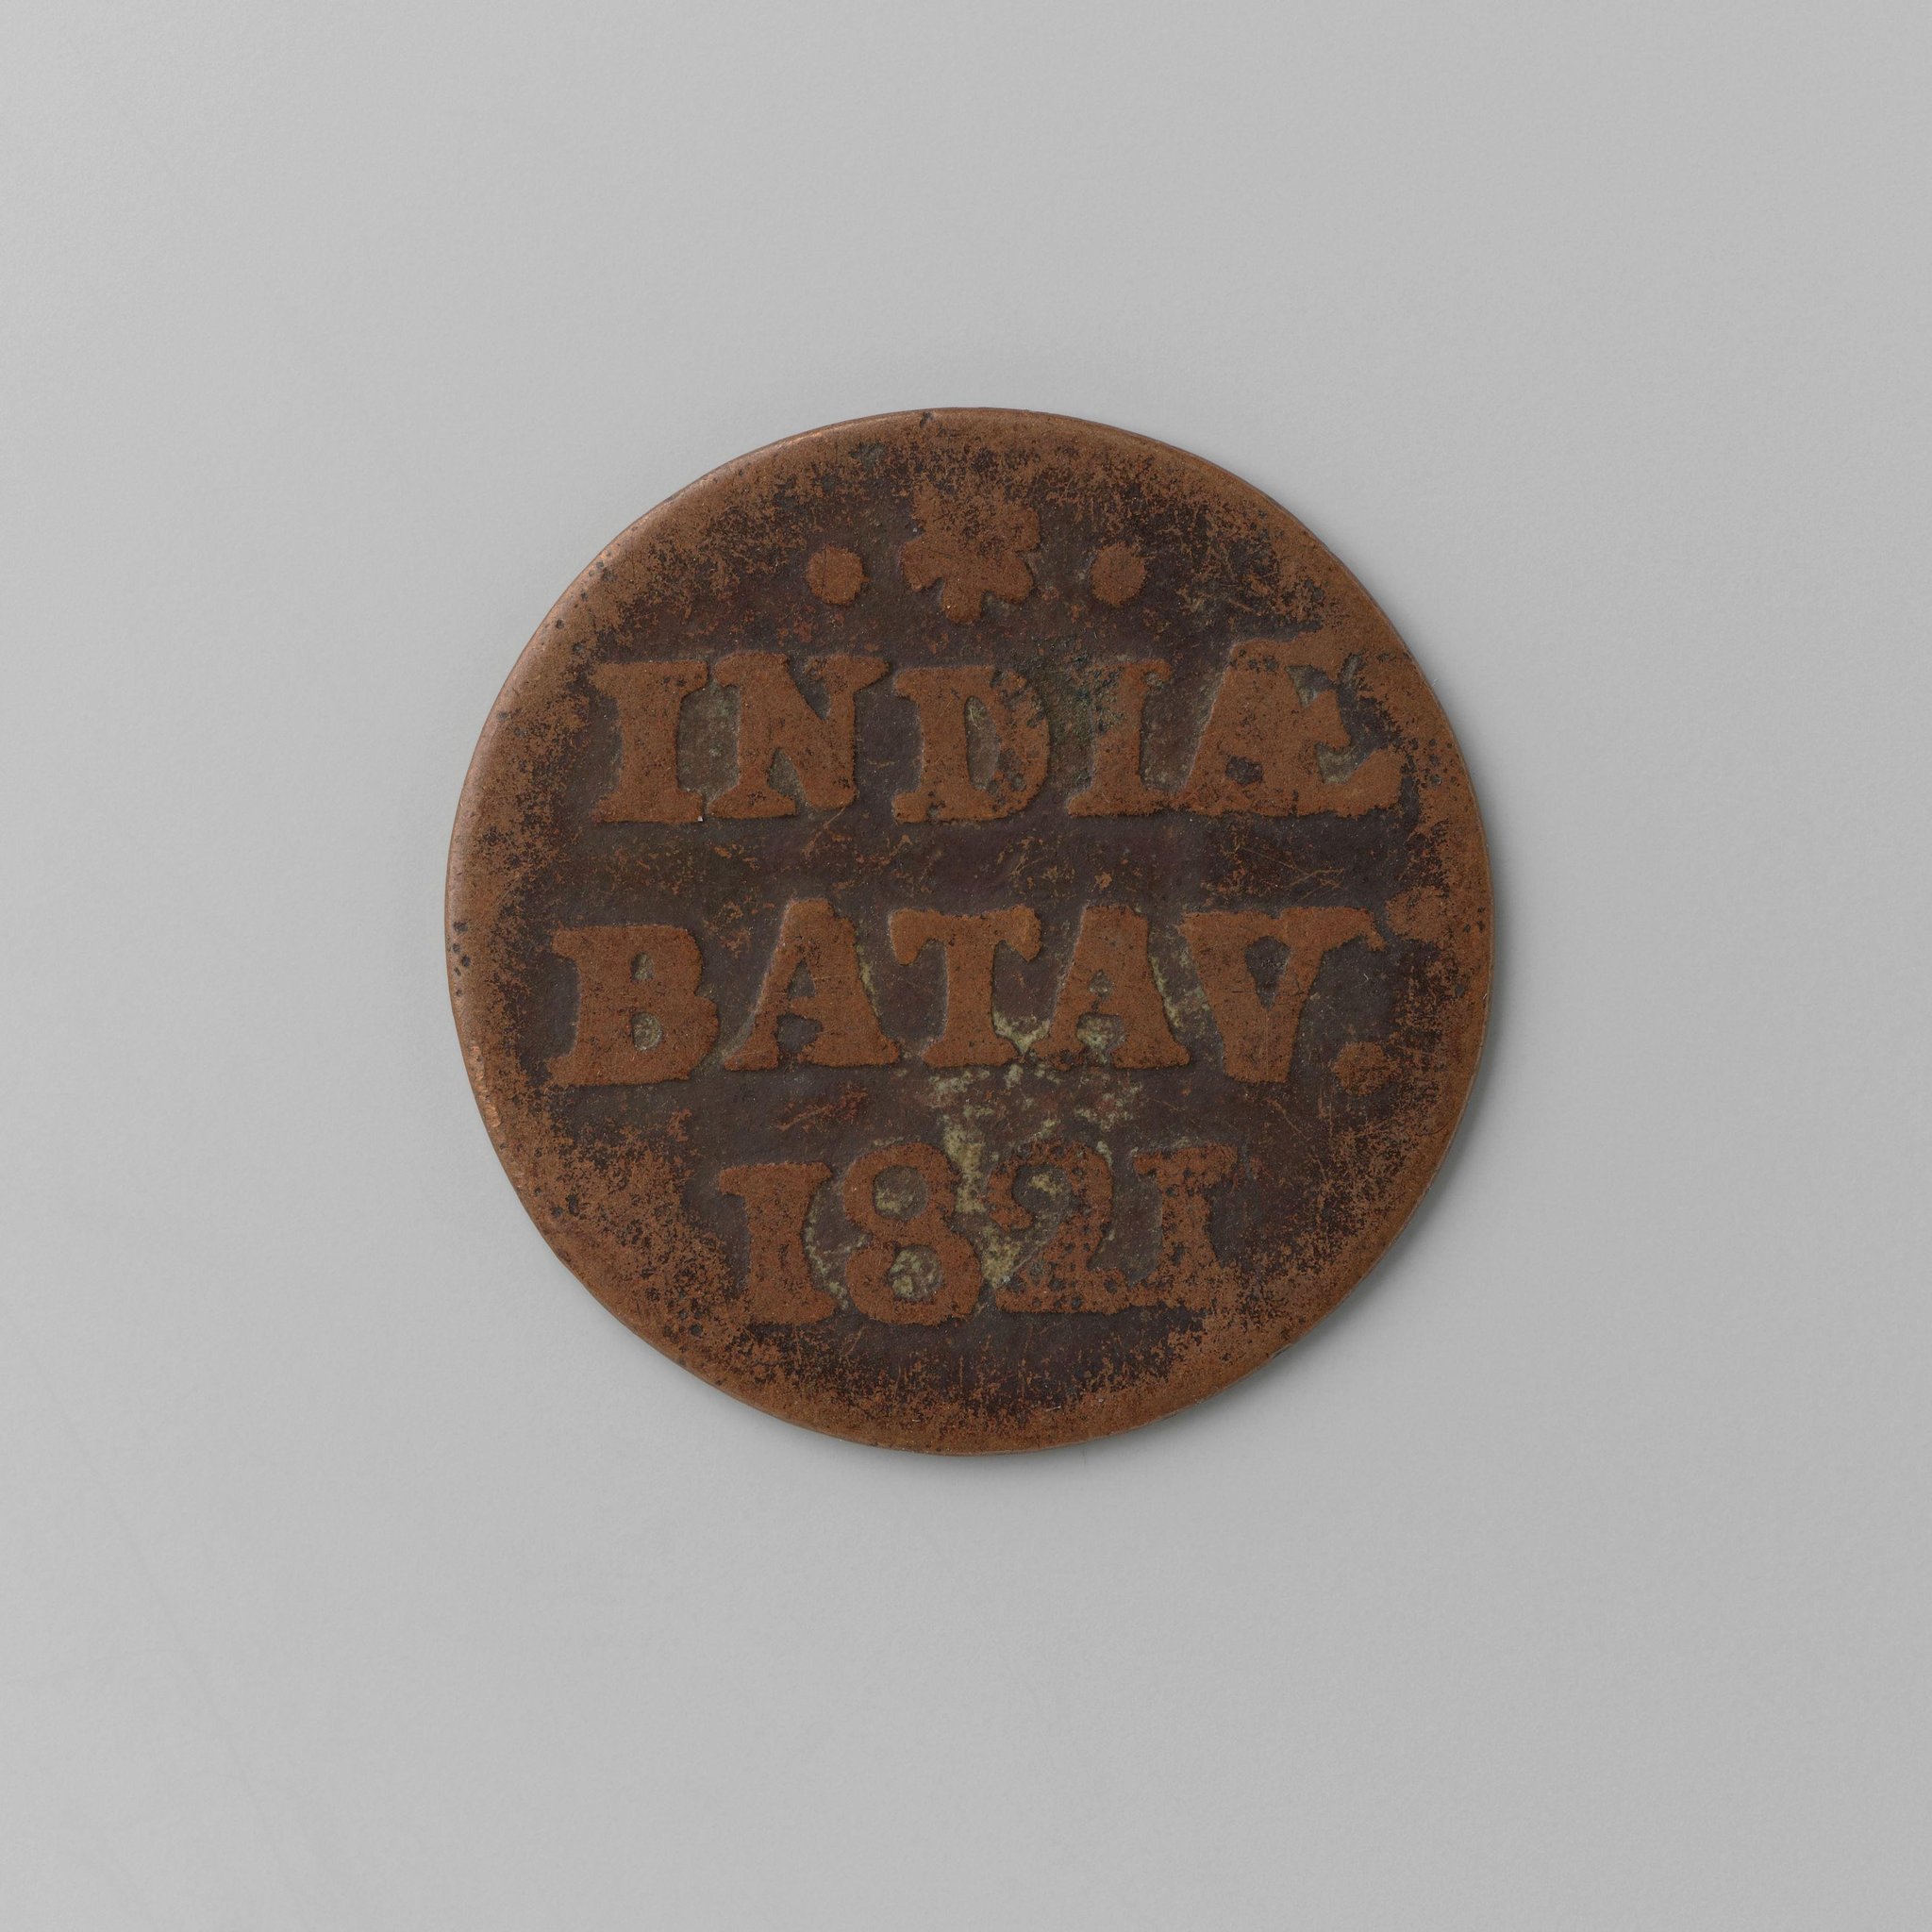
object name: coin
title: ½ duit van Nederlands Indië, 1821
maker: william i of the netherlands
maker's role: koning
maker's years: 1772-1843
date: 1821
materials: copper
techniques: striking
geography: surabaya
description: Koperen munt. Voorzijde: tussen waarde-aanduiding 5 1/32 G. gekroond generaliteitswapenschild. Keerzijde: tweeregelig opschrift, waarboven muntteken en waaronder jaartal. Gladde rand.